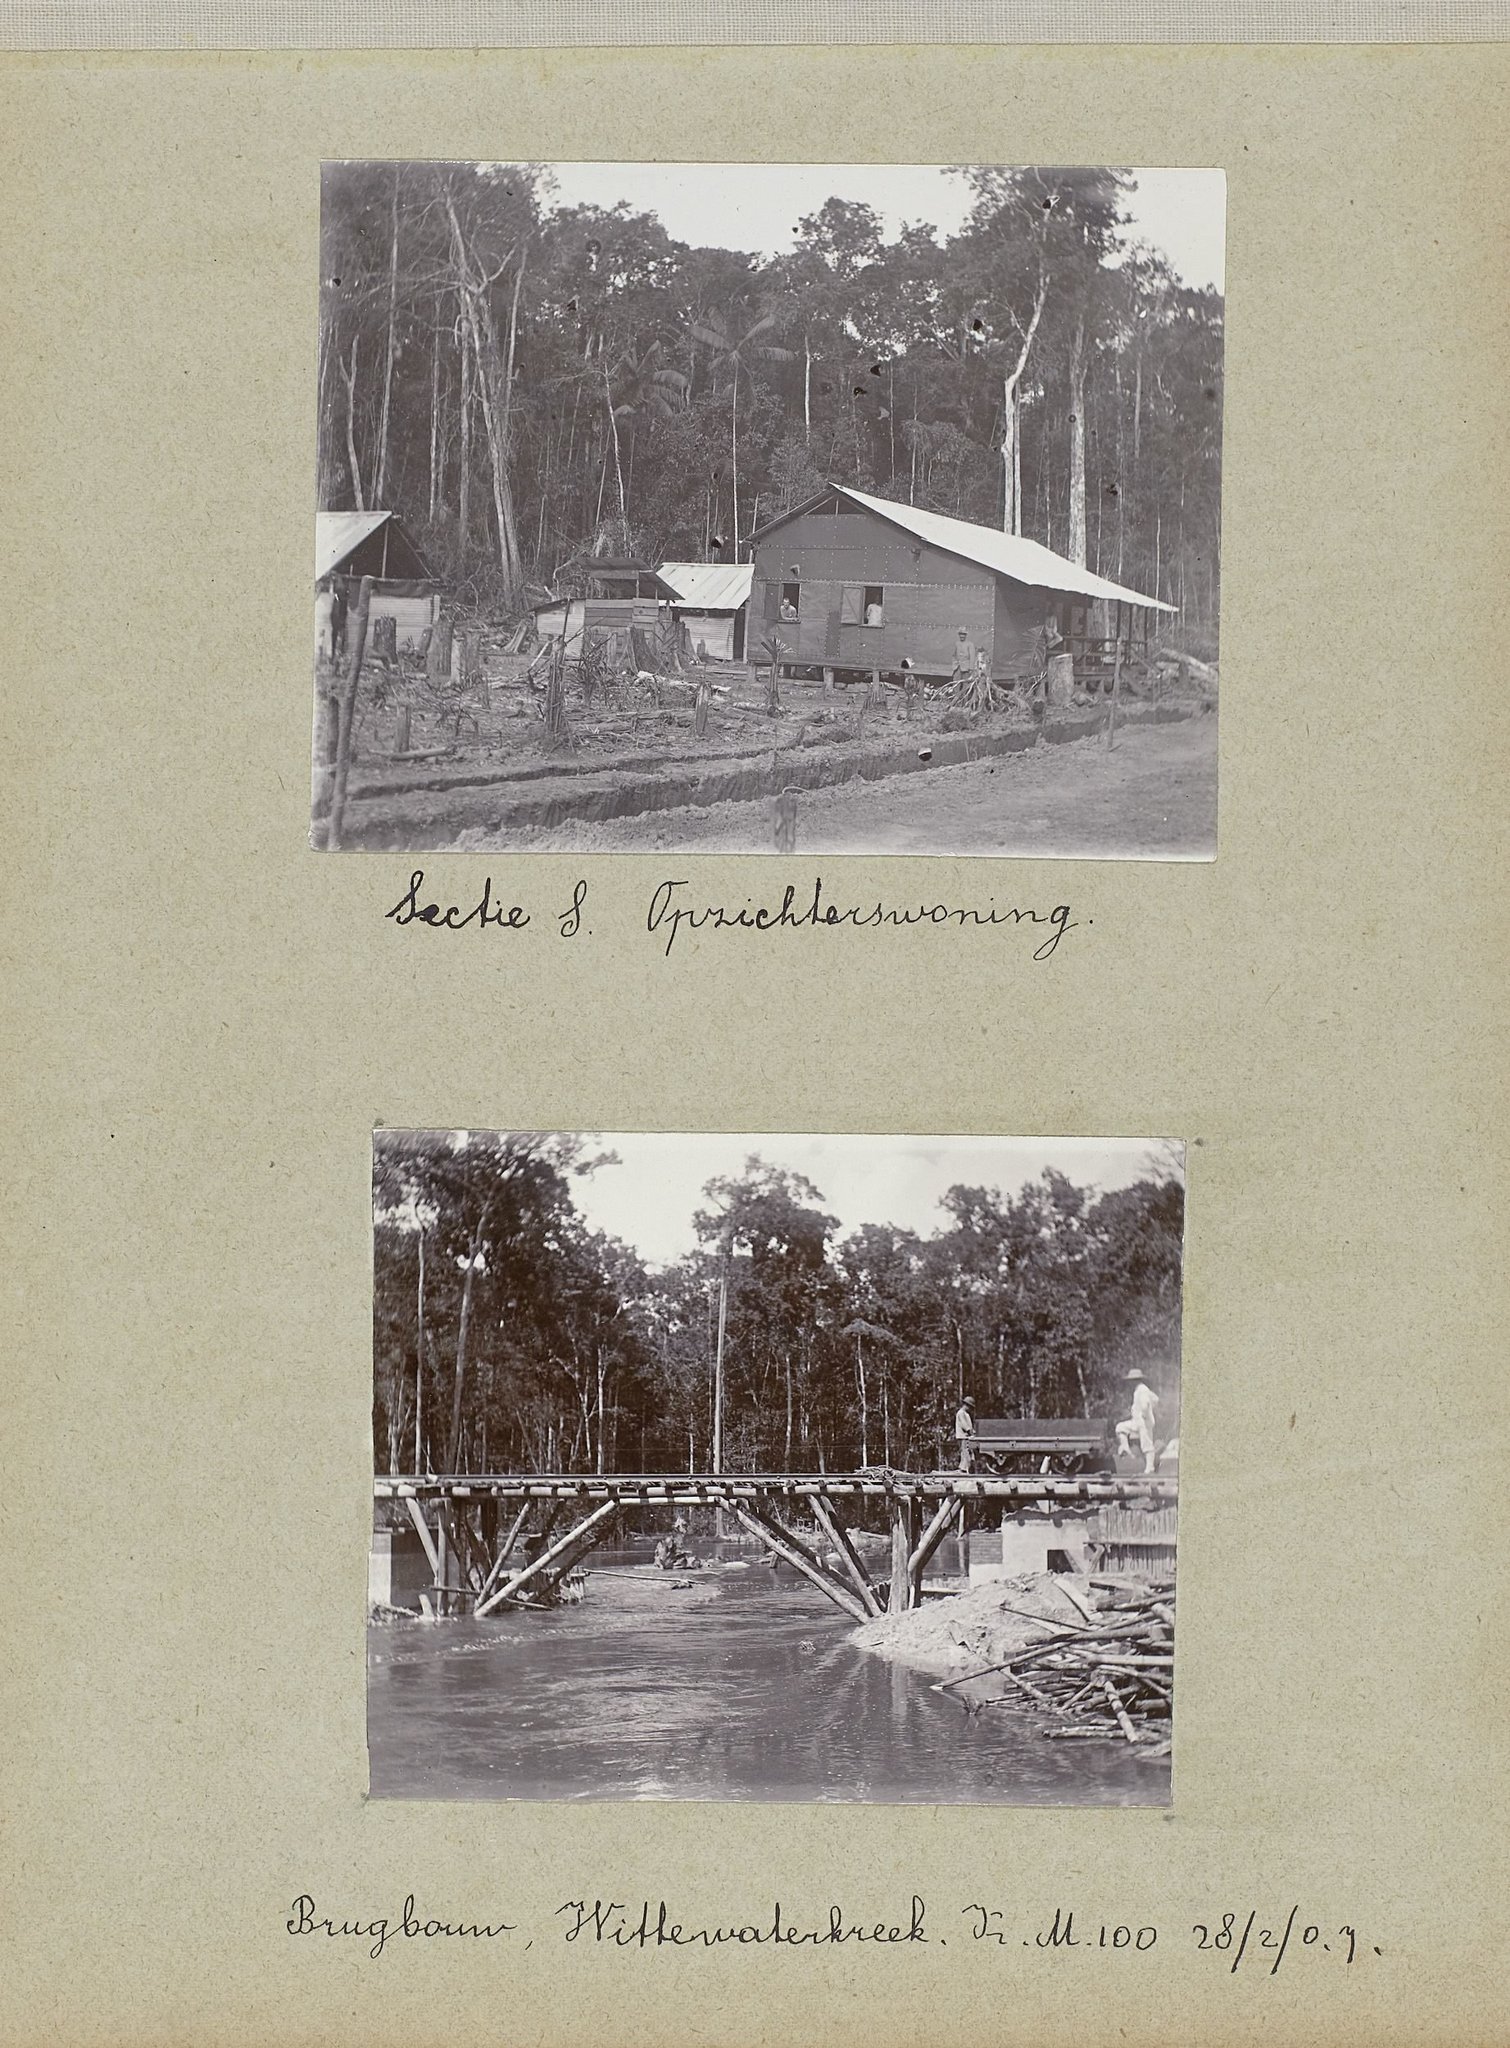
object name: photograph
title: Opzichterswoning / Brugbouw Wittewaterkreek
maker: Anonymous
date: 1907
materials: paper, photographic support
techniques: photography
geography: suriname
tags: jacob evert wesenhagen, railway, tramway; rack railway, suriname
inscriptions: inscription: ‘Sectie S. Opzichterswoning / Brugbouw, Wittewaterkreek. K.M. 100 28/2/07’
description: Albumblad met 2 foto's. Boven: de opzichterswoning langs het spoortrajet. Onder: bouw van de brug over de Wittewater kreek (Wittiewatra). Foto in het fotoalbum over de aanleg van de Lawaspoorweg in Suriname in de jaren 1903-1912. Onderdeel van een groep objecten afkomstig van de familie Wesenhagen in Suriname.